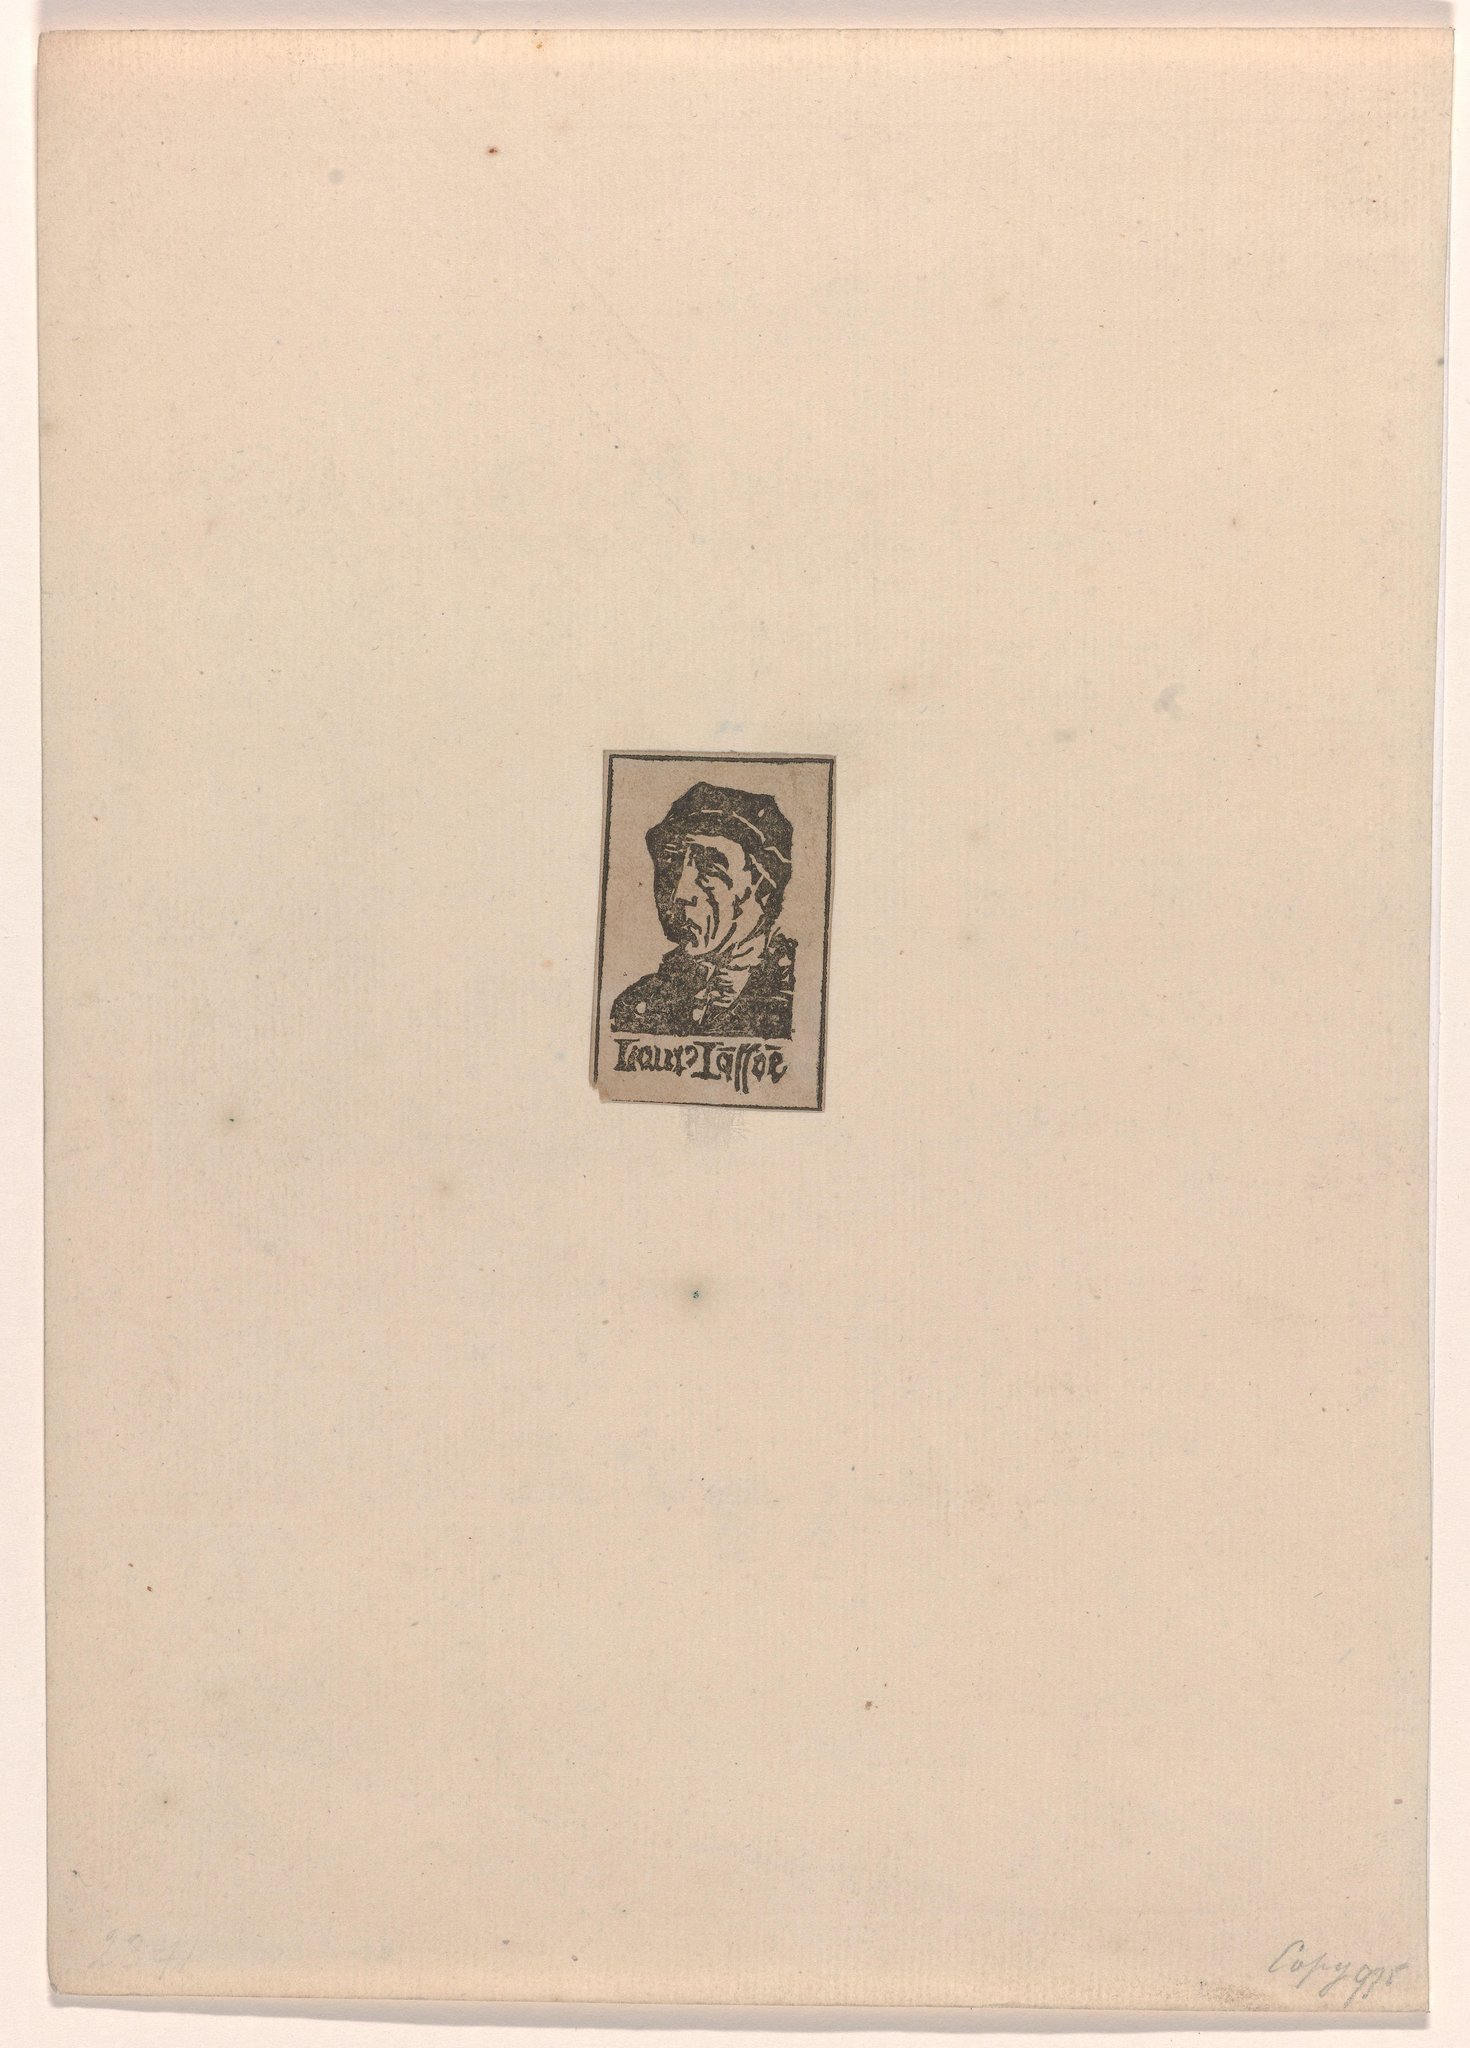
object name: print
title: Portret van Laurens Jansz. Coster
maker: Anonymous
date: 1600-1699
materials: paper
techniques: woodcut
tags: haarlem, historical persons, printer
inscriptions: collector's mark: Lugt 2228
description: In omlijsting portret van Jan Laurens Coster, uitvinder van de boekdrukkunst, met hoofddeksel naar links. Onder de geportretteerde zijn naam.